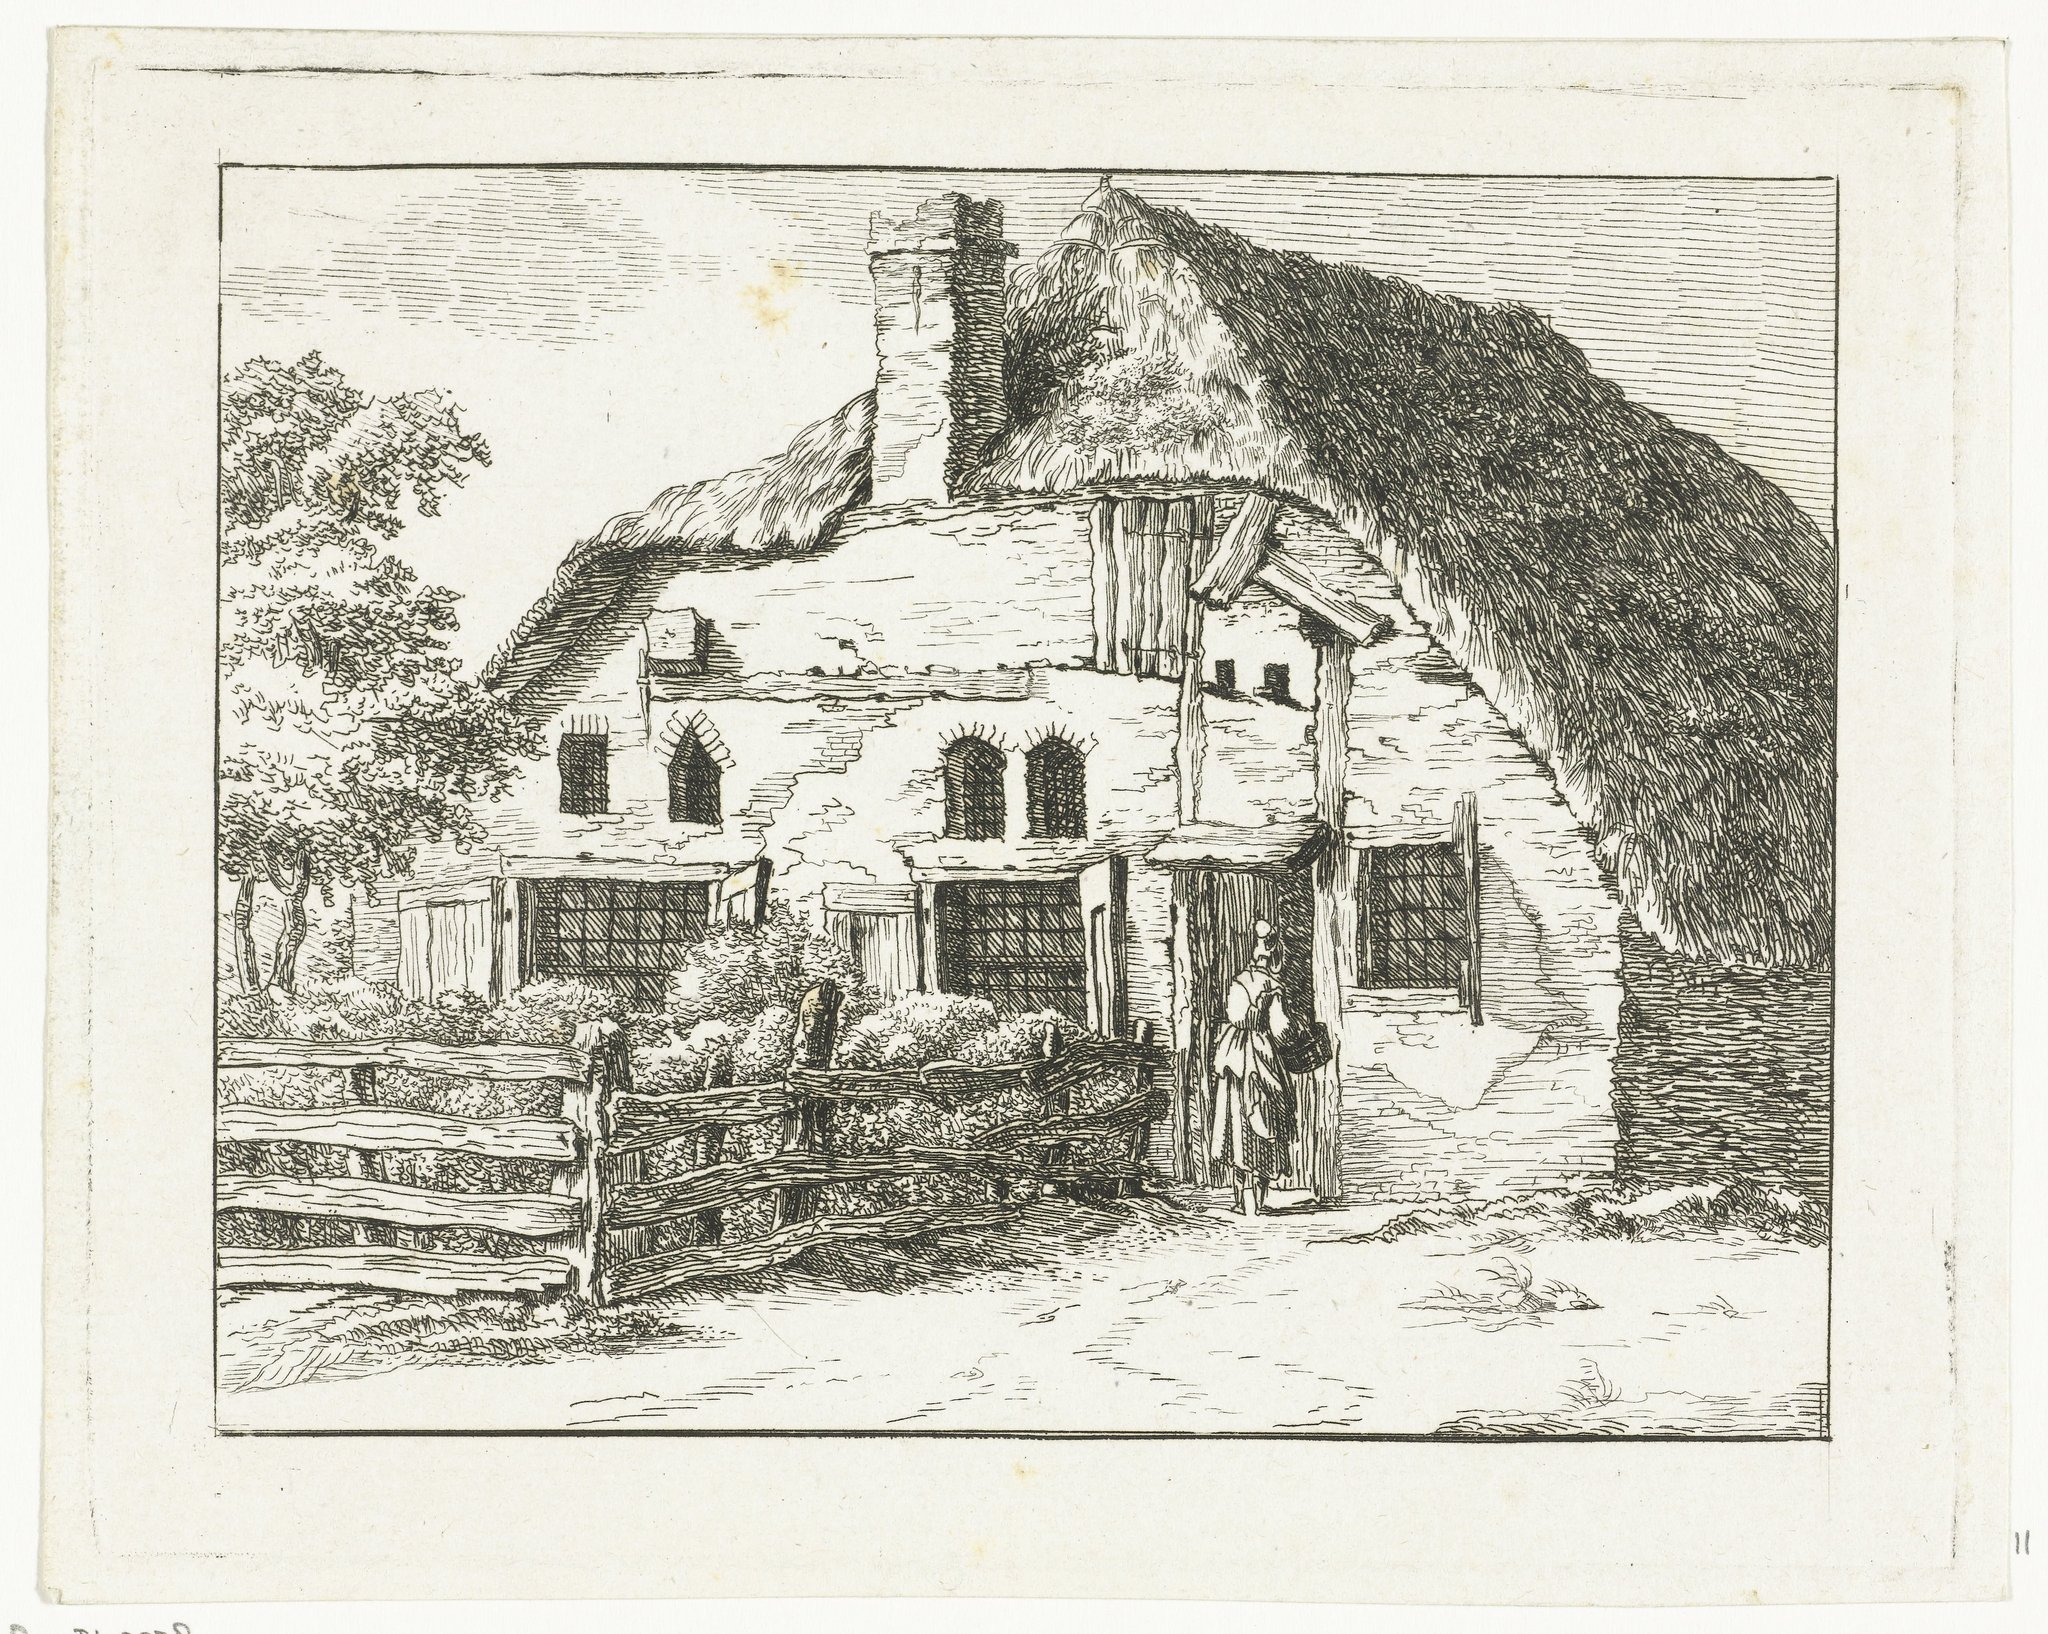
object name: print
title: Vrouw met een mand voor een huis te Staphorst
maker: anthonie van den bos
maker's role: draughtsman, print maker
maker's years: 1763-1838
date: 1778-1838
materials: paper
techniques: etching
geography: netherlands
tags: farm (building)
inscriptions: collector's mark: Lugt 2228